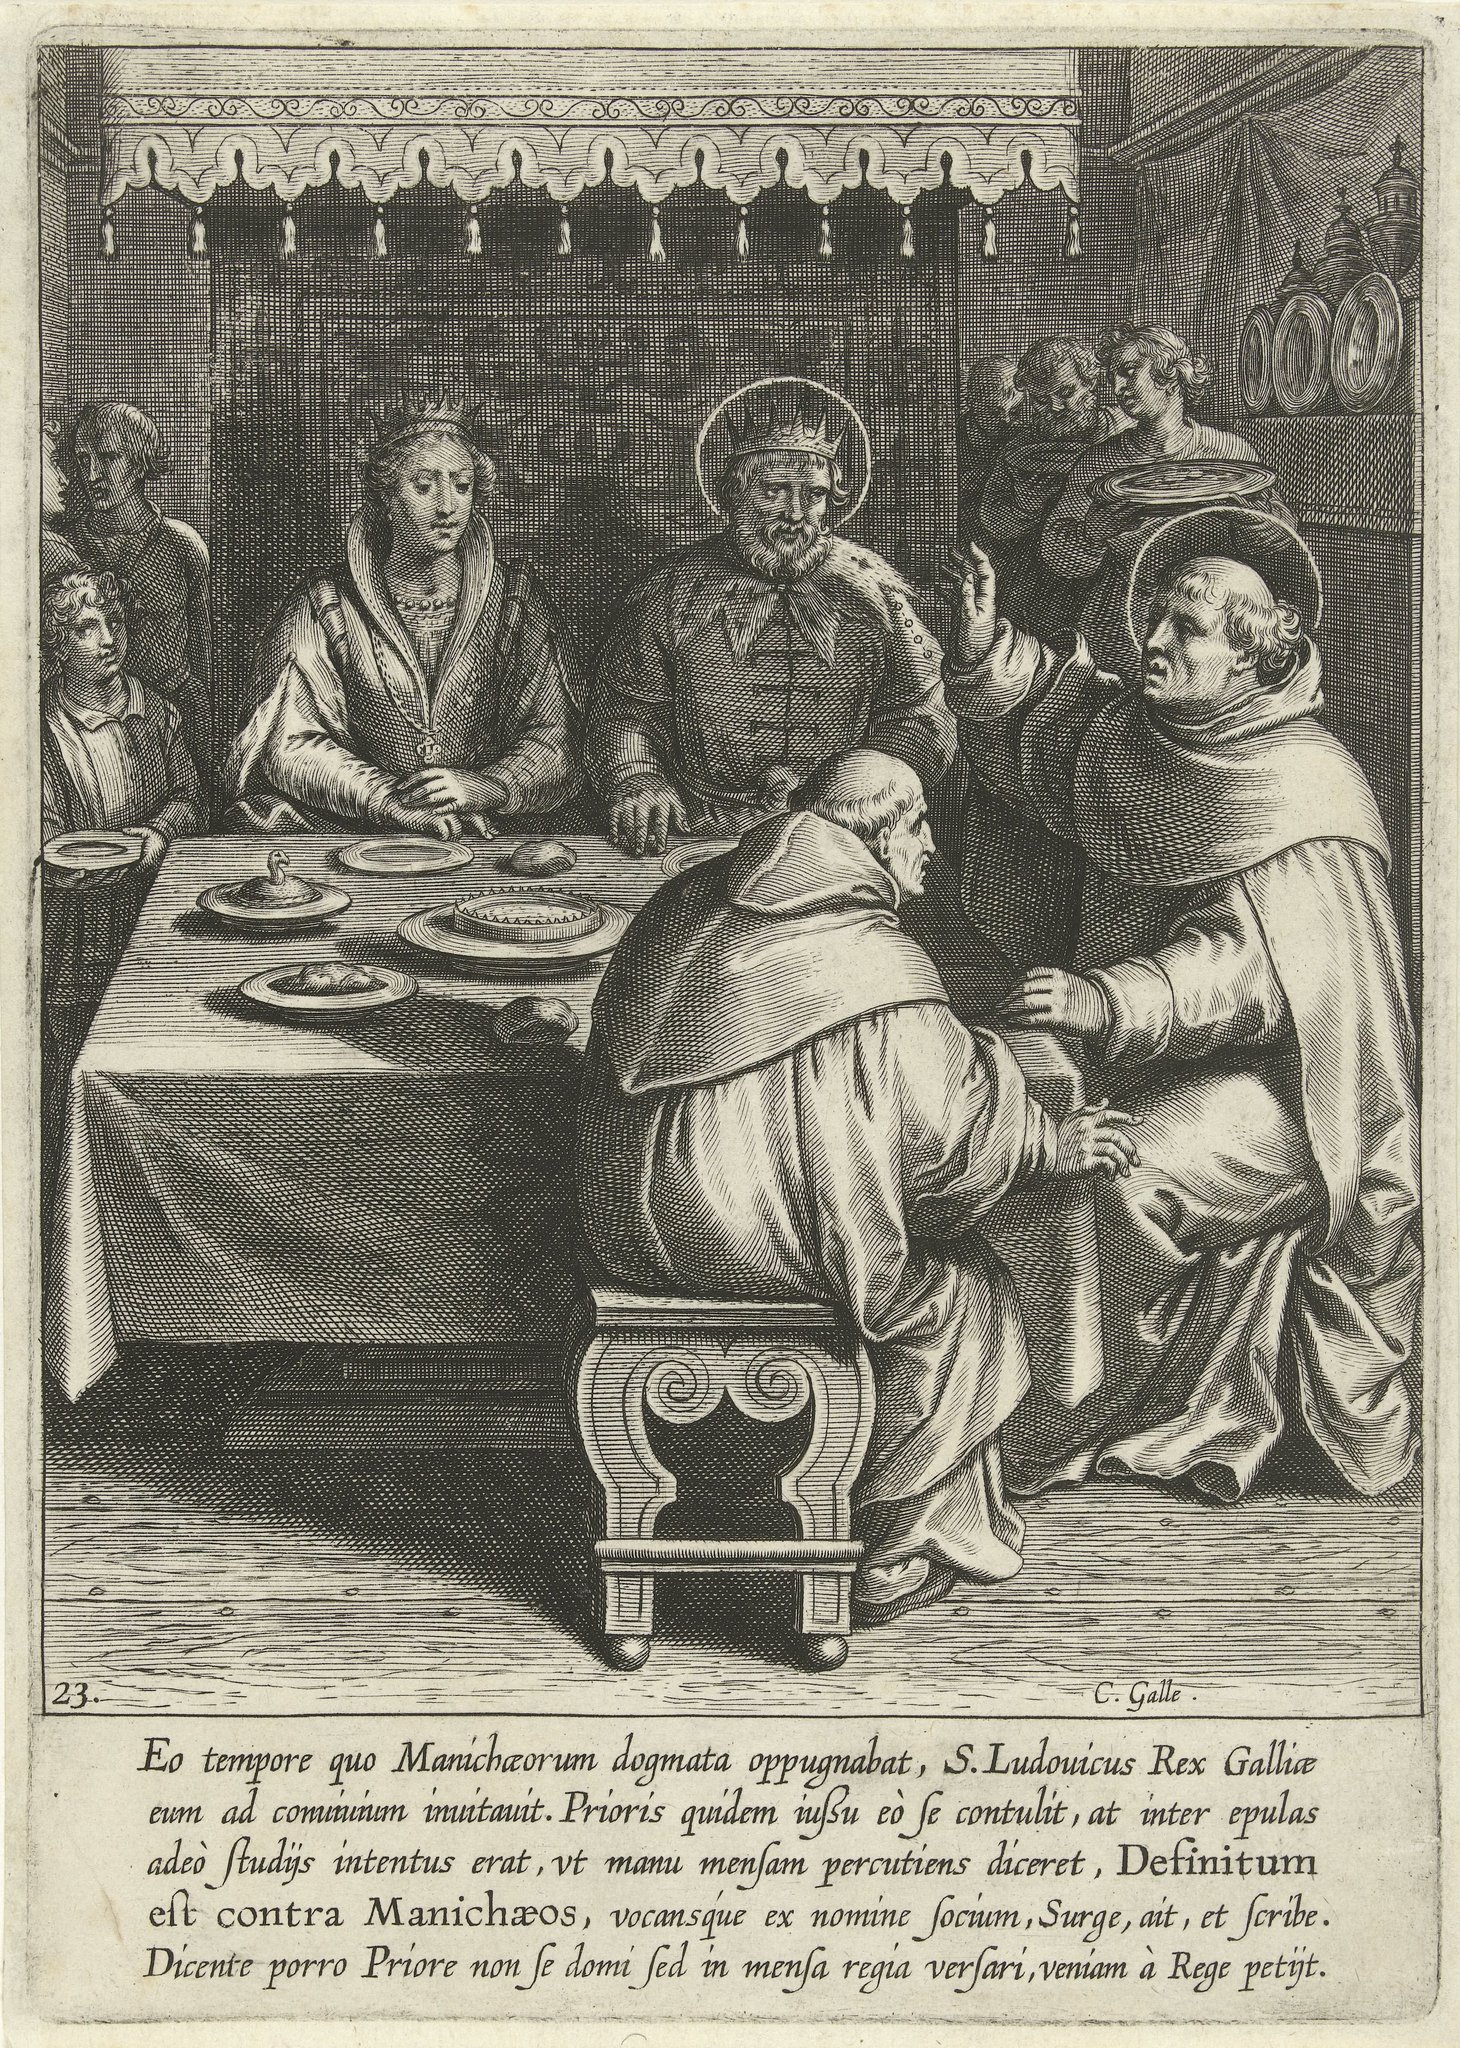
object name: print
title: Het leven van de heilige Thomas van Aquino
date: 1610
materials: paper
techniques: engraving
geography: antwerp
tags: thomas van aquino, the dominican theologian, 'angelic doctor' thomas of aquino; possible attributes: book, (chain with) sun, dove, girdle of chastity, lily, model of church, monstrance (or chalice), mitre (under feet), star (on breast)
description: Prent uit een serie van 30 prenten die het levensverhaal van Thomas van Aquino verbeelden. De prenten, naar ontwerp van en uitgegeven door Otto van Veen, zijn door C. Boel, E. van Paenderen, C. Galle en G. Swanenburgh vervaardigd.